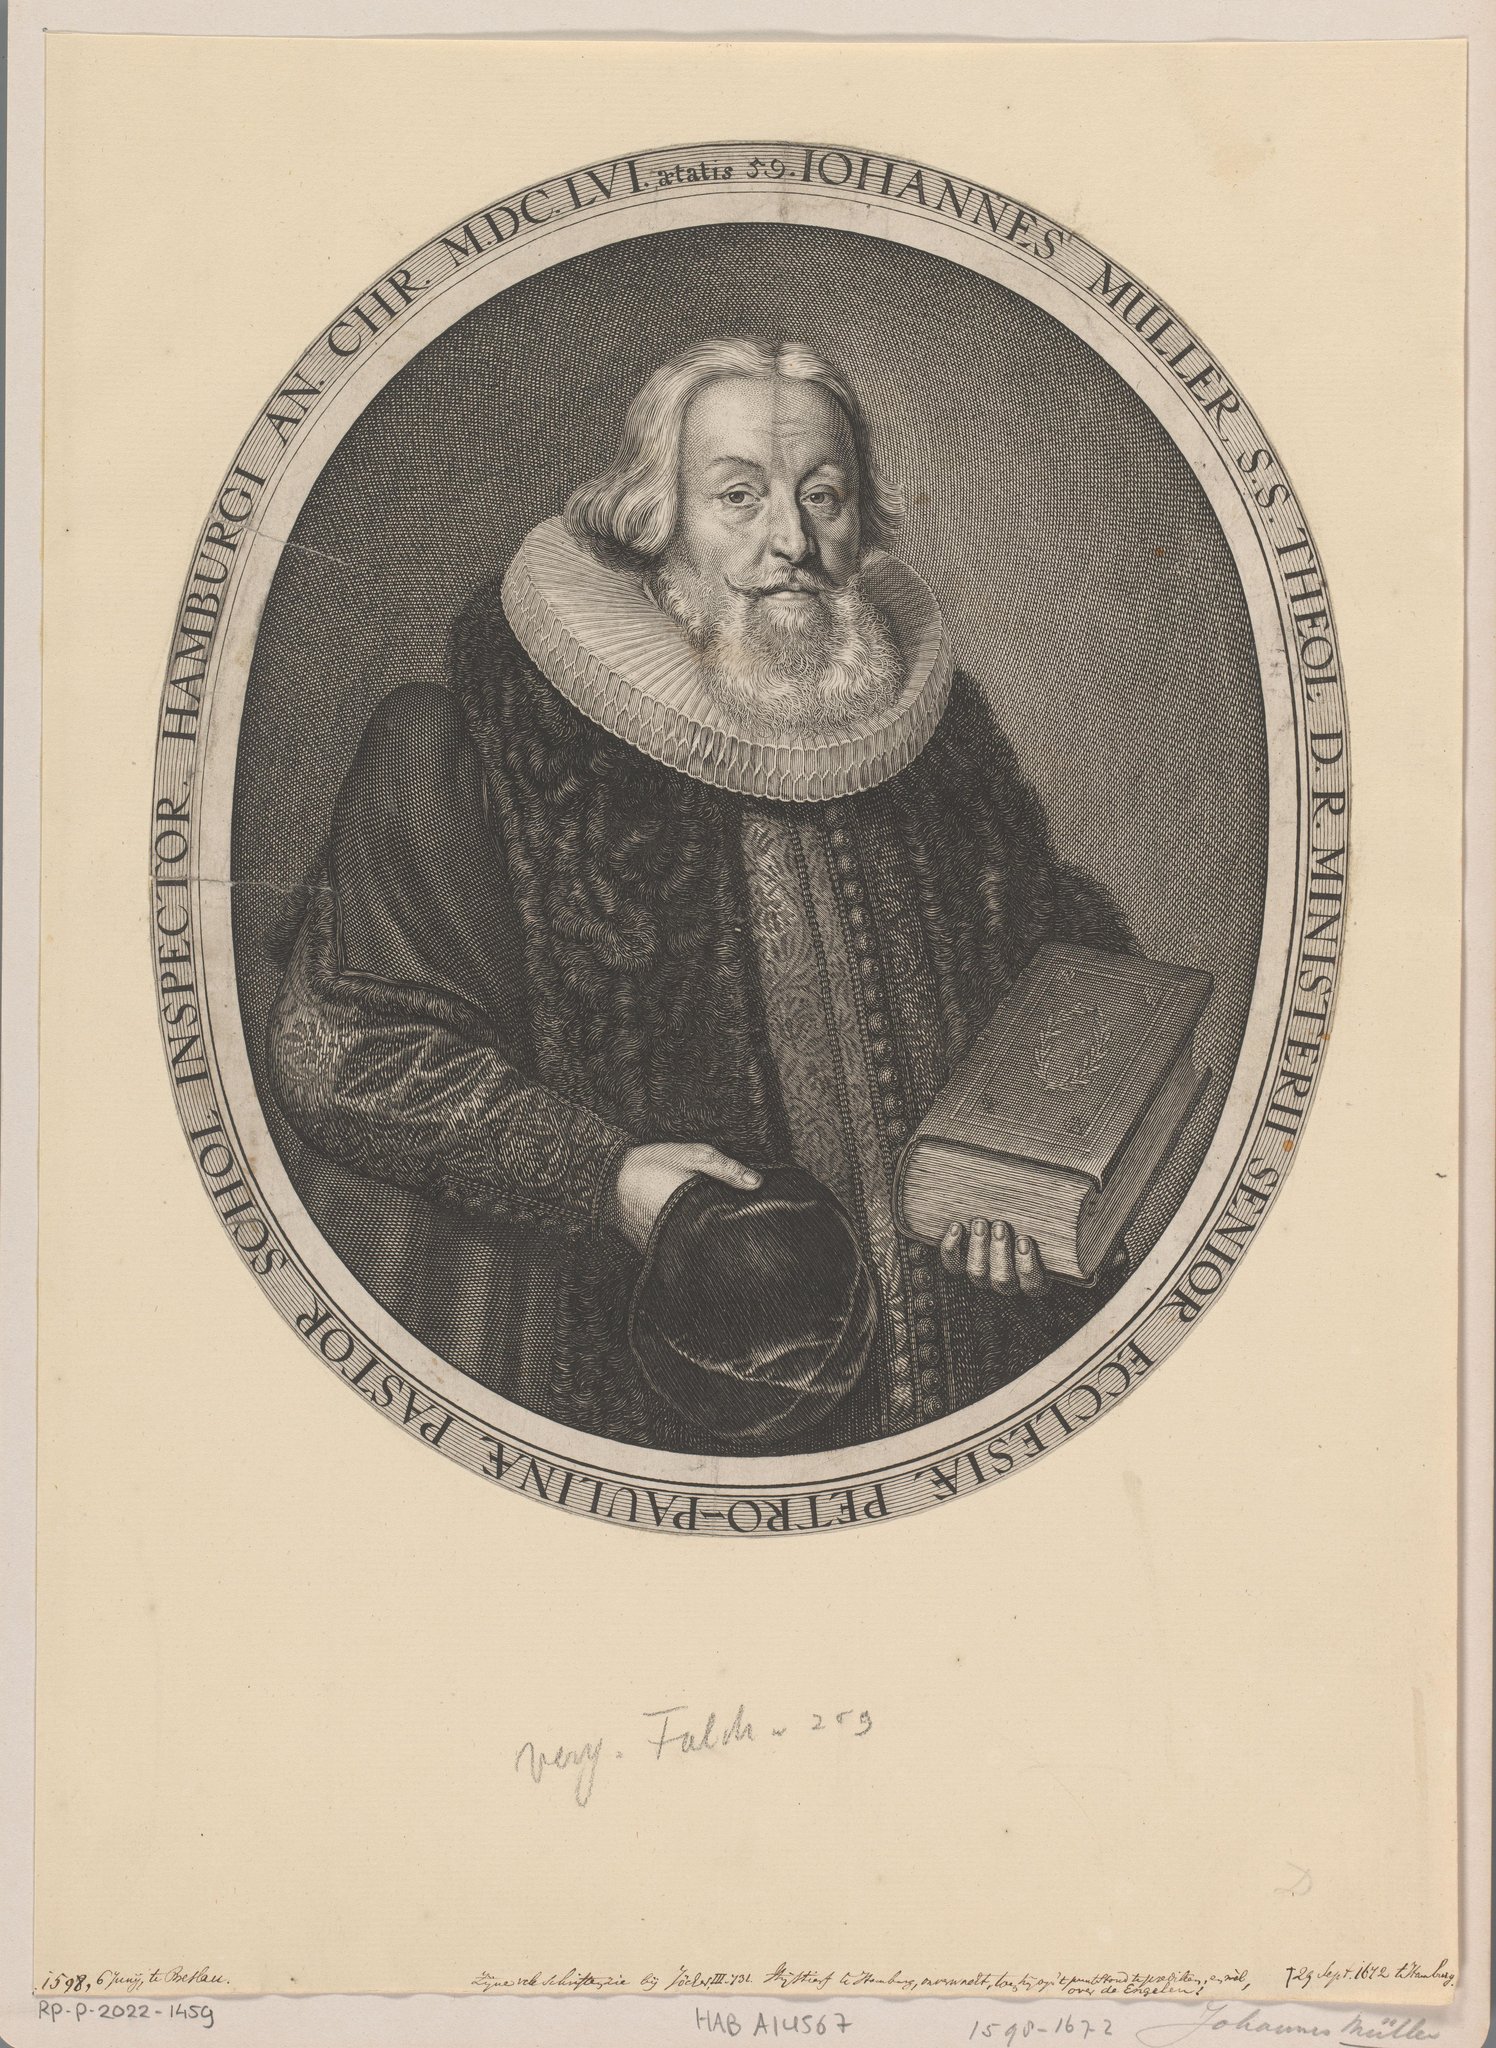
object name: print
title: Portret van Johann Müller op 59-jarige leeftijd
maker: jeremias falck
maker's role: print maker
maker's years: 1609-1677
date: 1656-1677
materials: paper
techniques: engraving, snipping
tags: theologian, historical persons